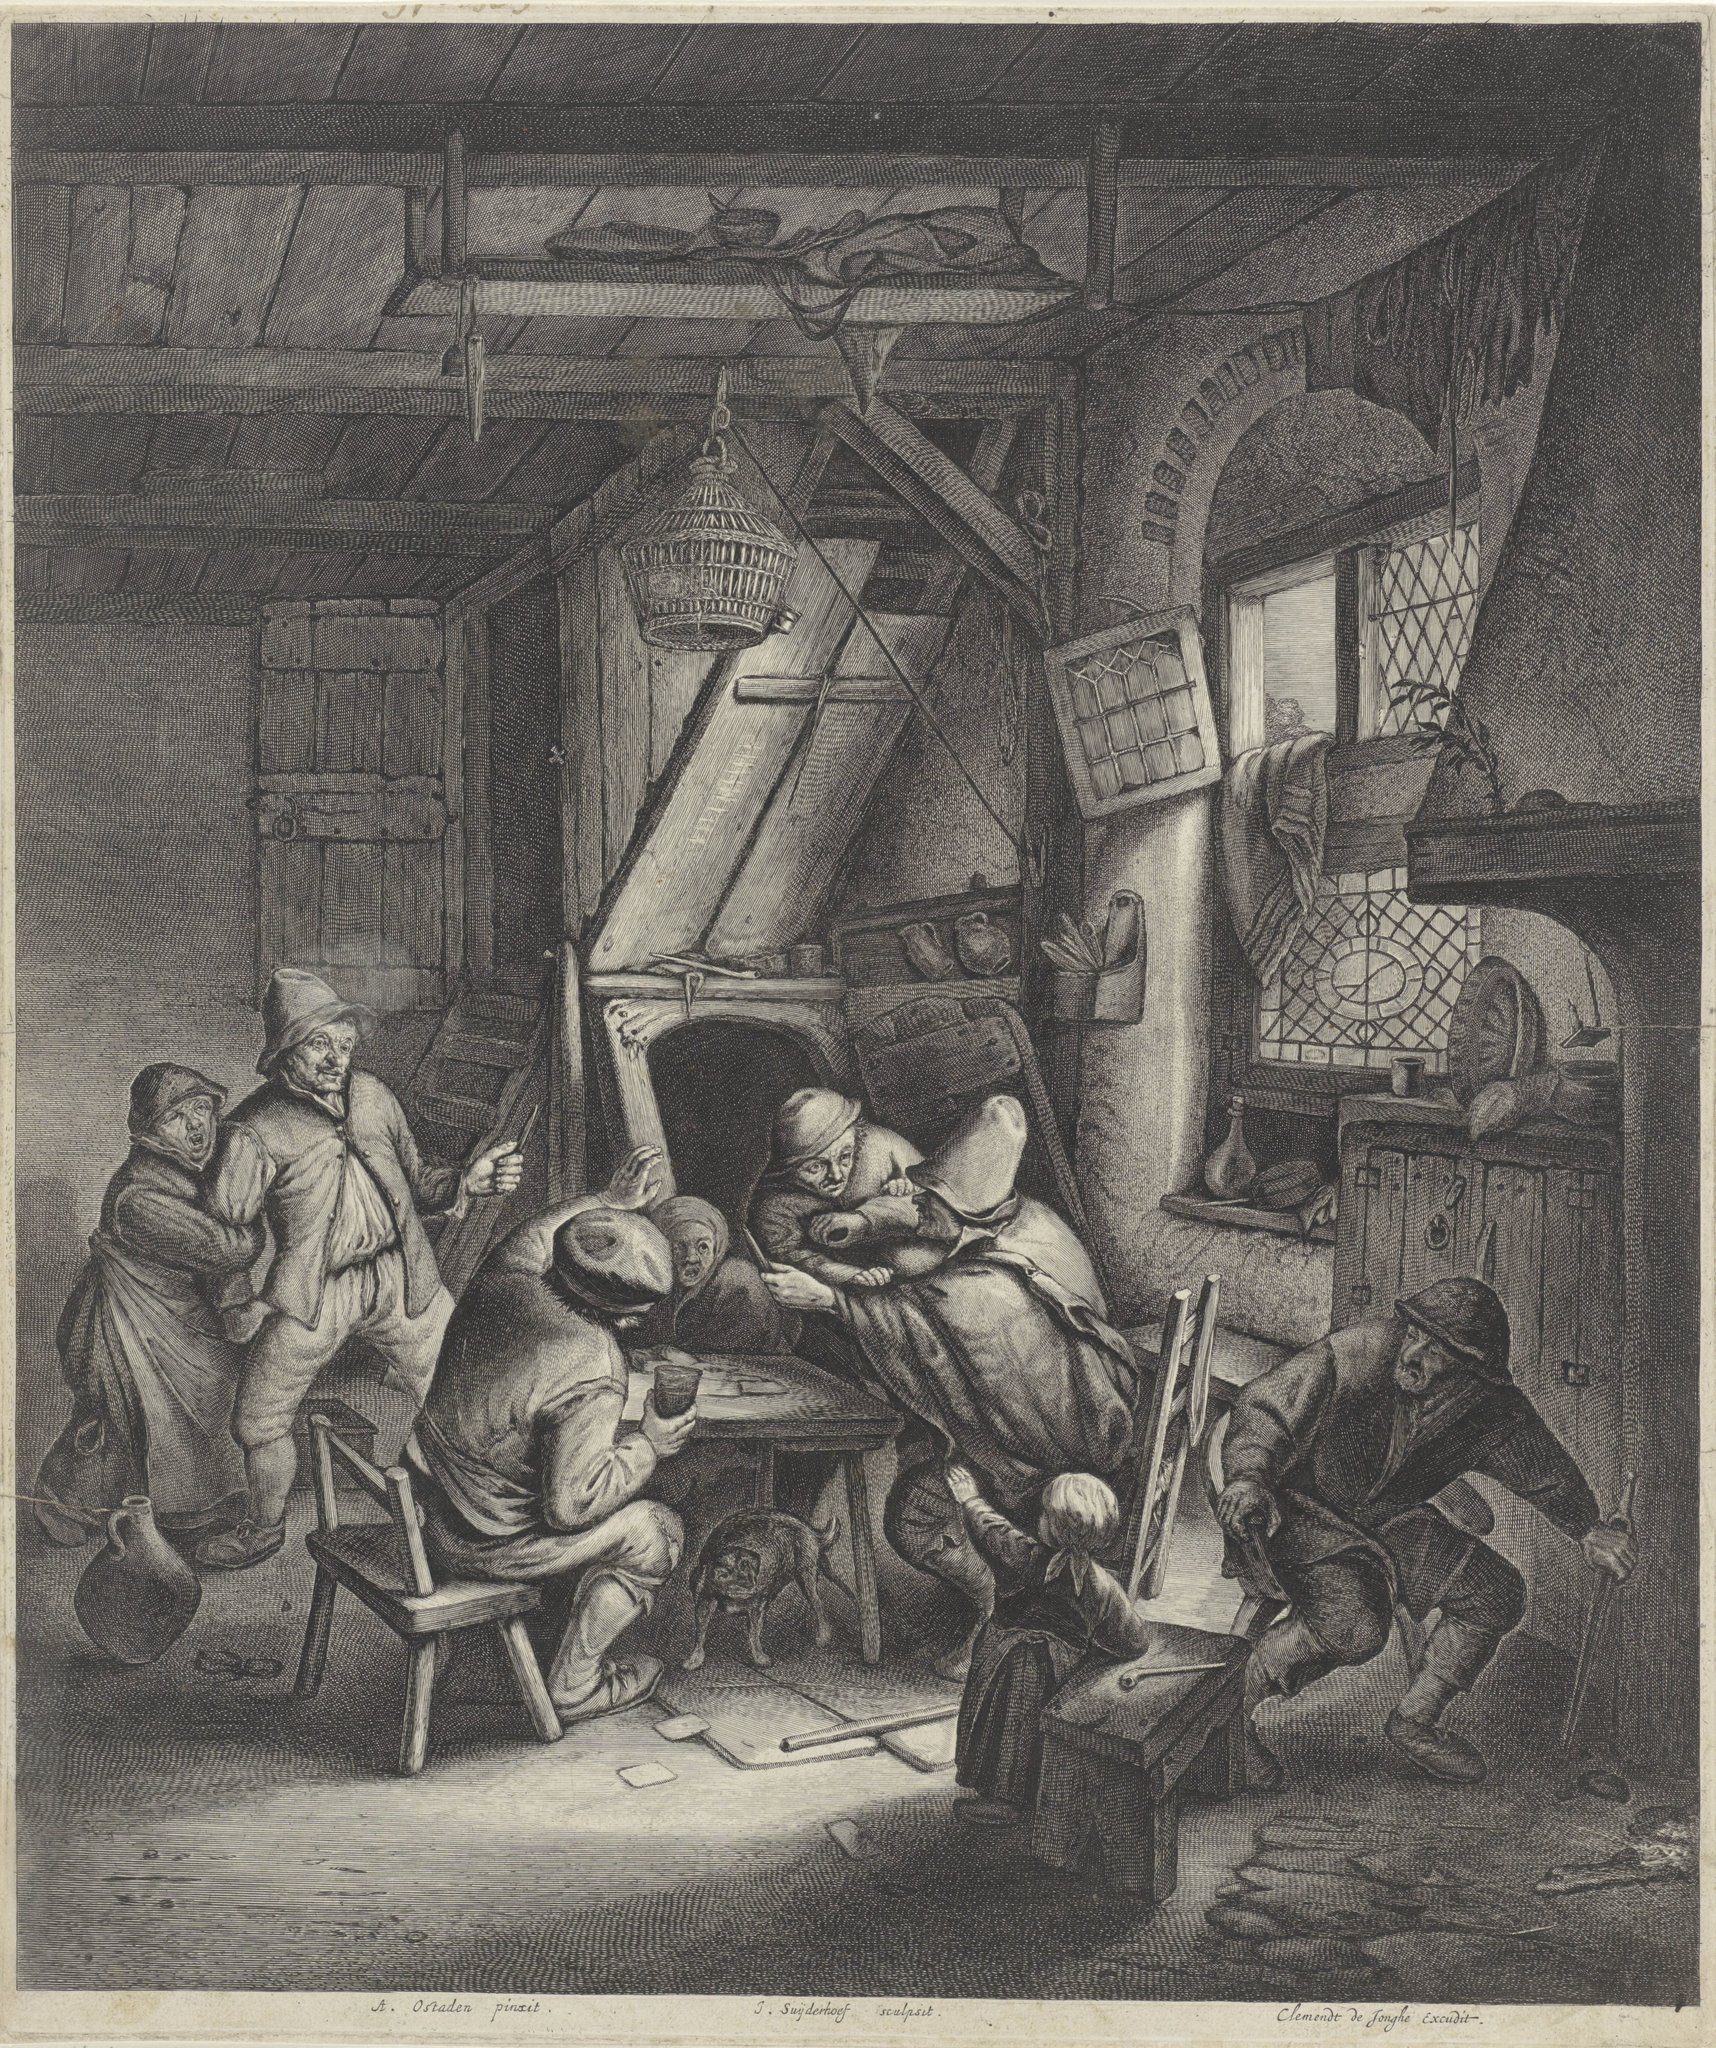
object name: print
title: Ruziënde boeren rond een tafel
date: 1643-1677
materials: paper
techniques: engraving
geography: amsterdam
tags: inn, coffee-house, public house, etc., drunken brawl (usually peasants fighting in an inn)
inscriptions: collector's mark: Lugt 240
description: In een herberginterieur staan twee boeren op het punt om elkaar met getrokken messen aan te vallen. De zittende boer rechts wordt in bedwang gehouden door de man naast hem. De staande boer links wordt door een vrouw bij de arm gepakt. Op de voorgrond een kind en een oude man.